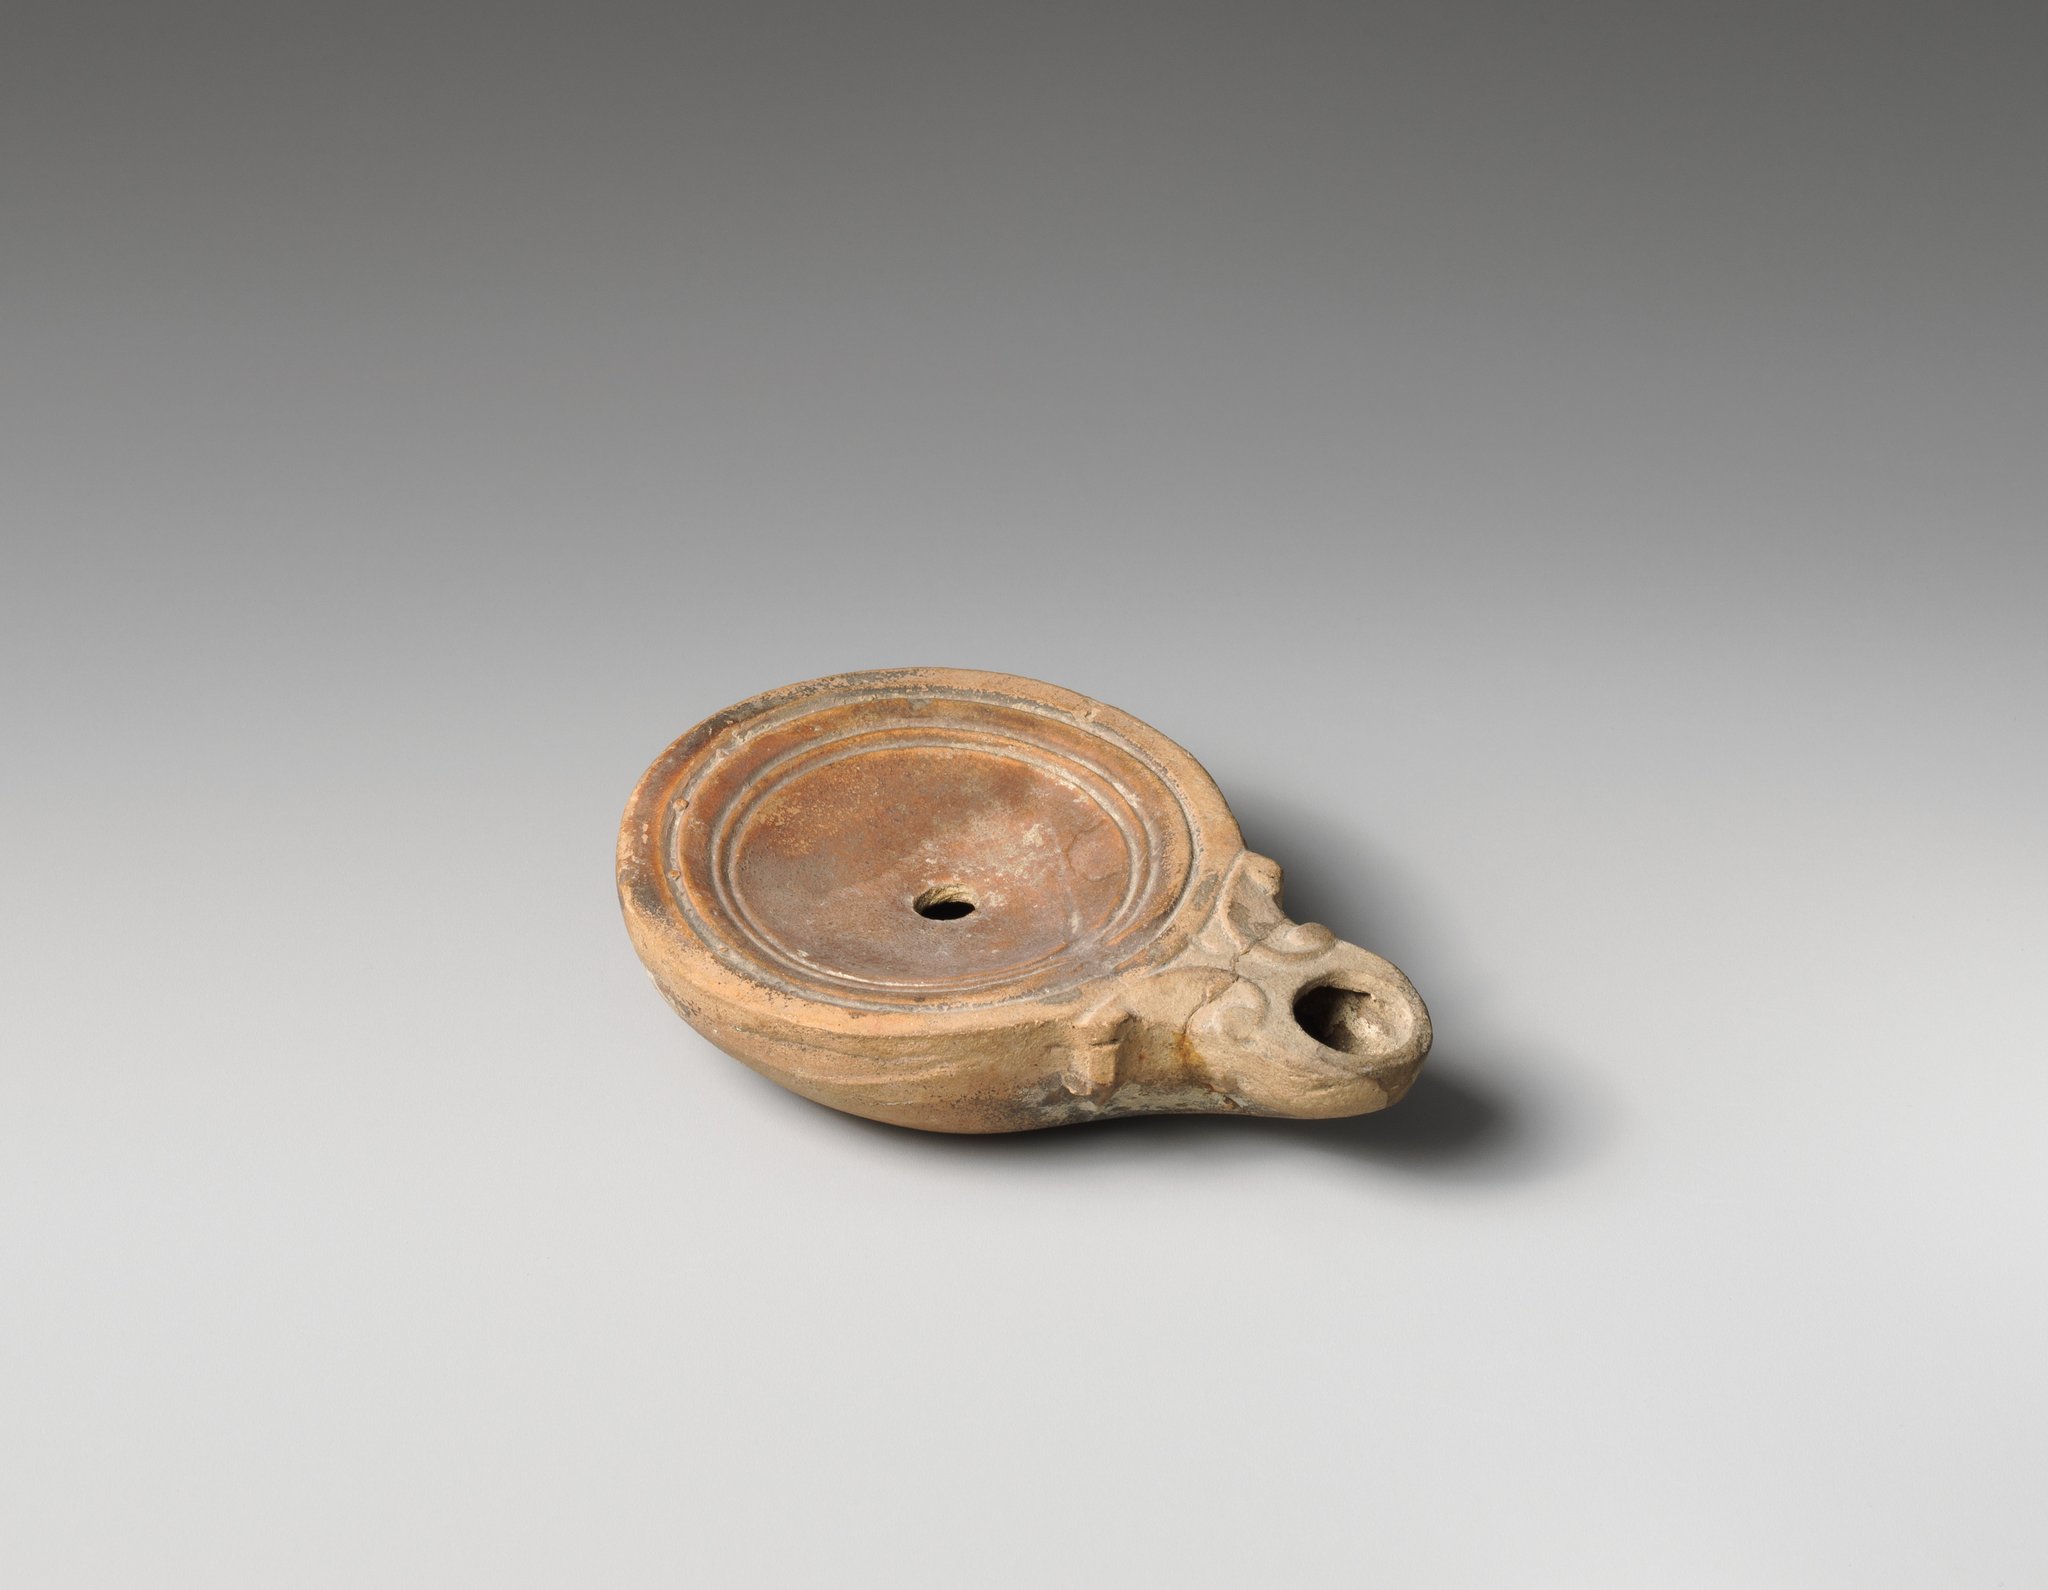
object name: lamp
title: Terracotta oil lamp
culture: roman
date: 40-100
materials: terracotta